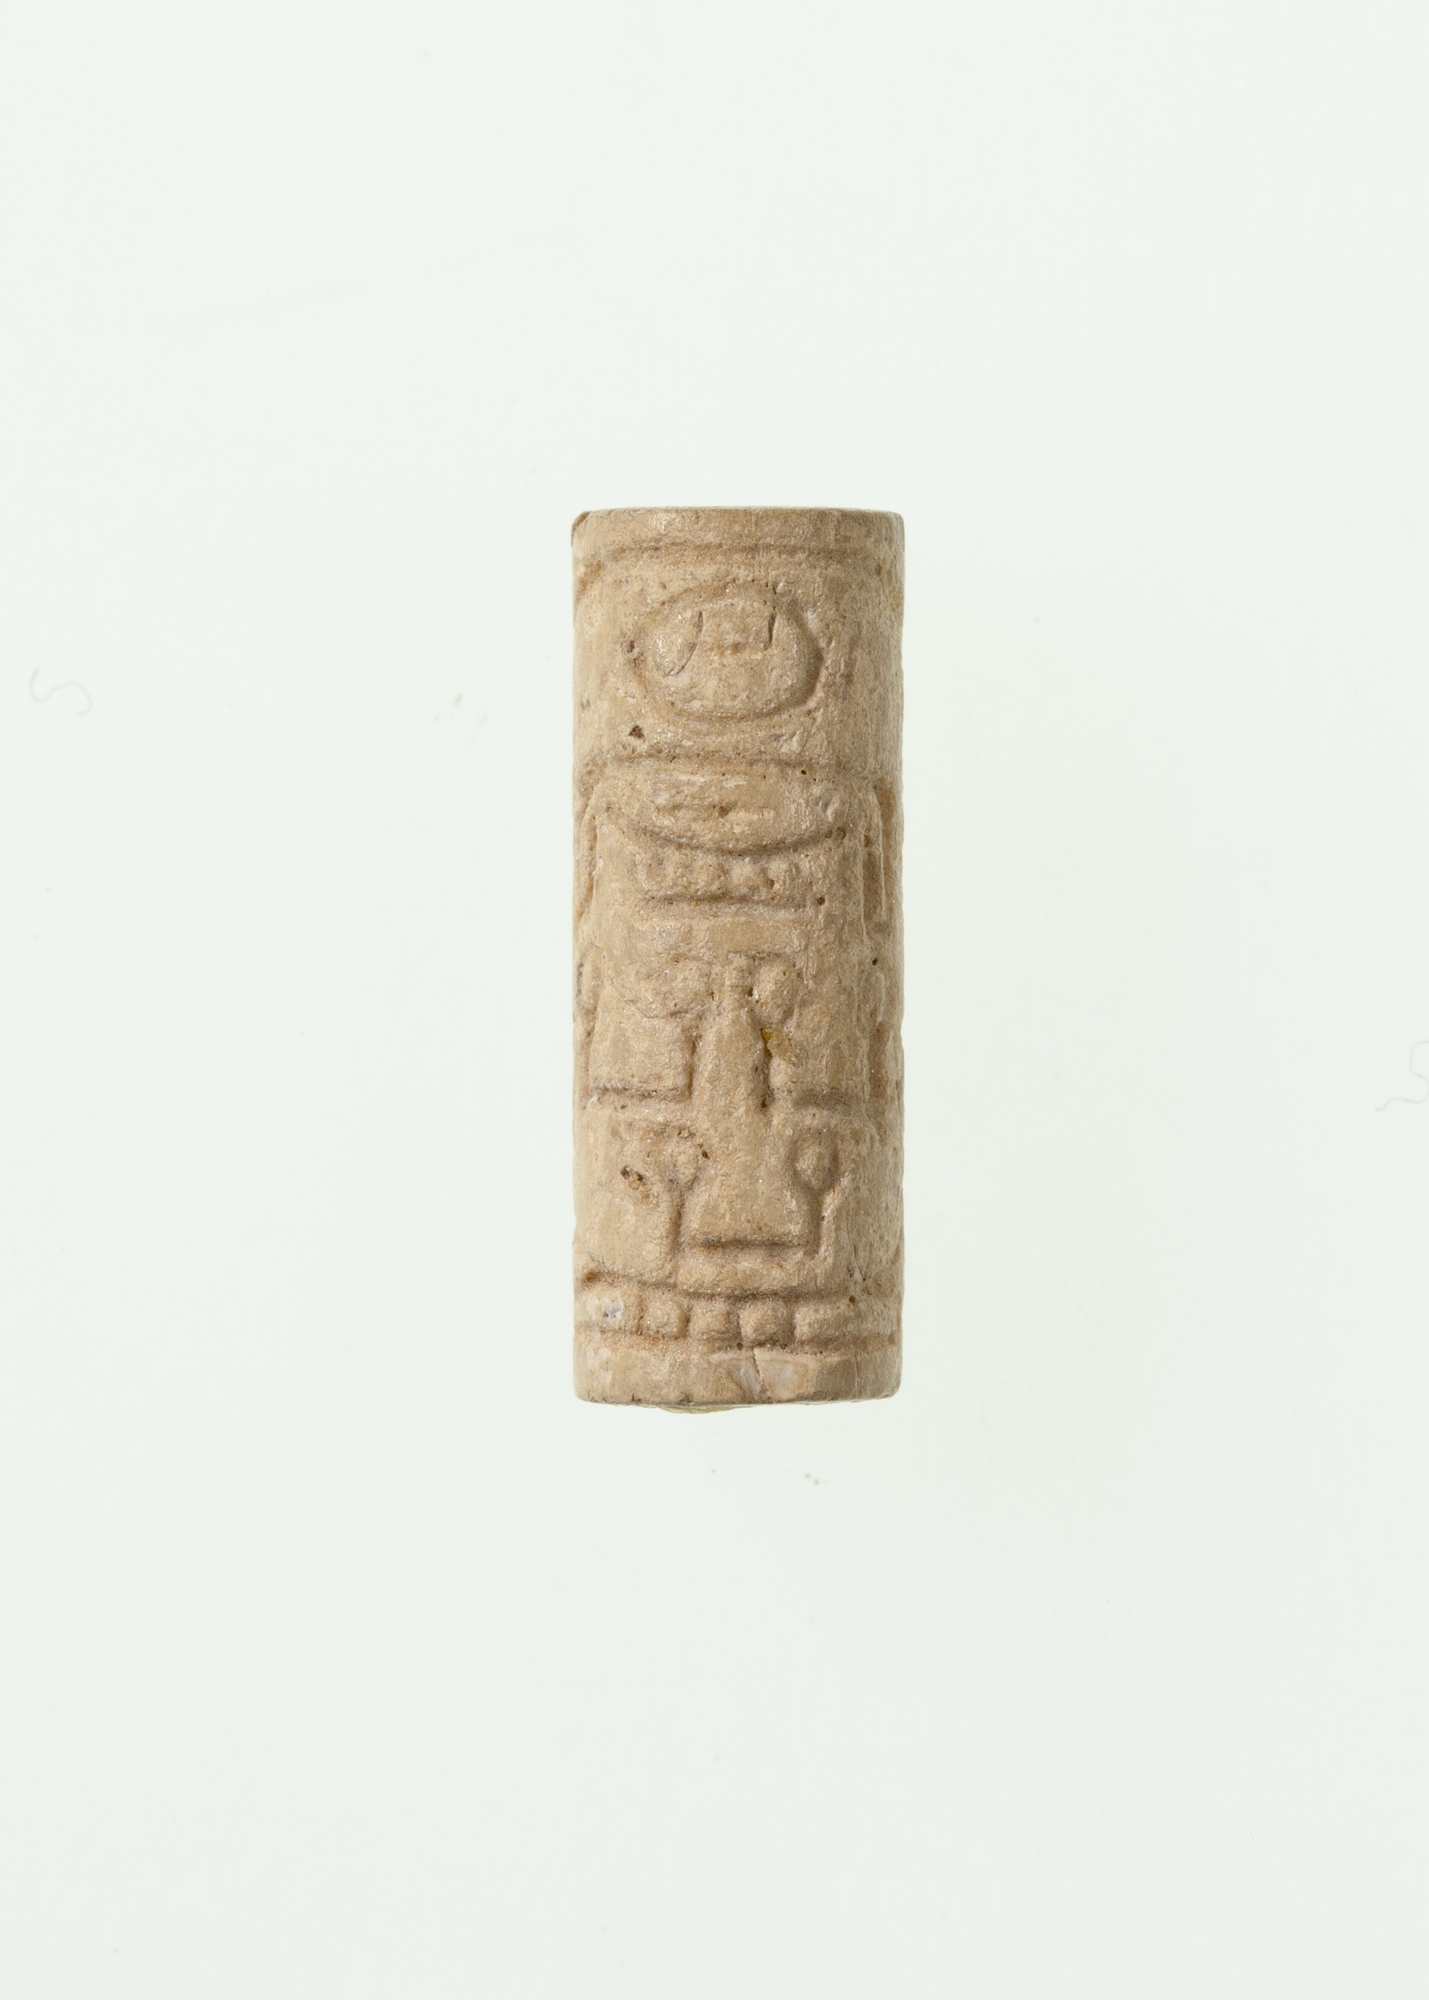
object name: cylinder seal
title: Cylinder seal with the name of Amenemhat II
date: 1802-1550 BCE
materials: stone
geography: egypt